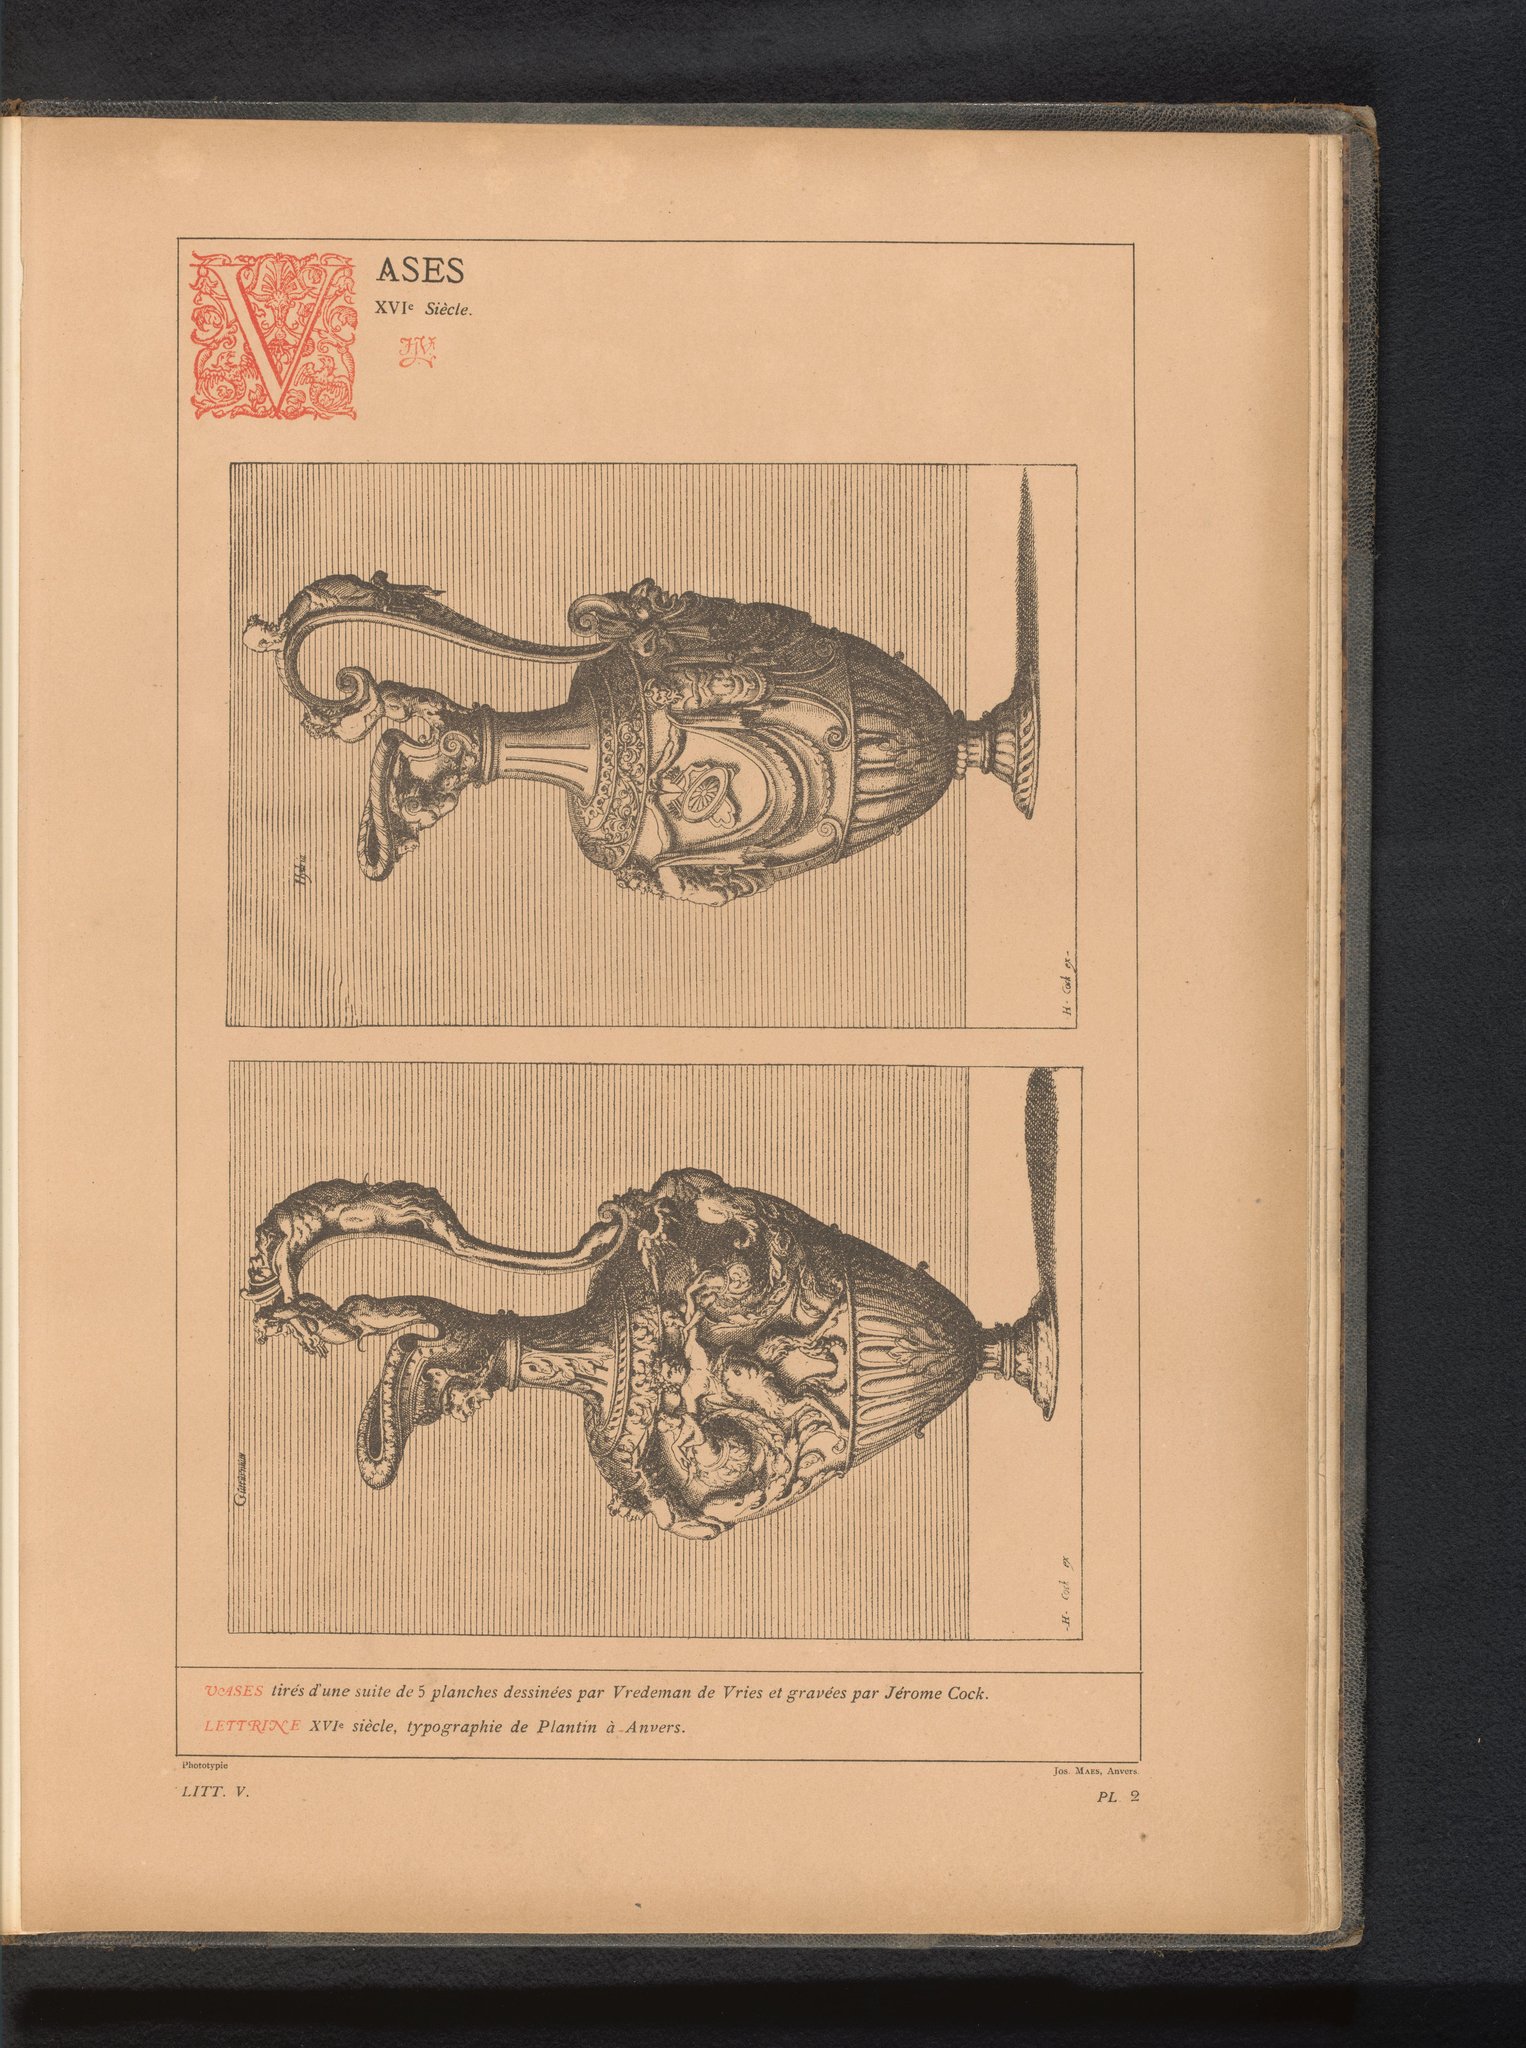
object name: page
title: Vases, XVIe Siècle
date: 1876-1881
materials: paper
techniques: photolithography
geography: antwerp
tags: containers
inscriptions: inscription: ‘LITT. V. - PL. 2.’, inscription: ‘VASES tirés d'une (...)’, monogram: ‘JJvY’